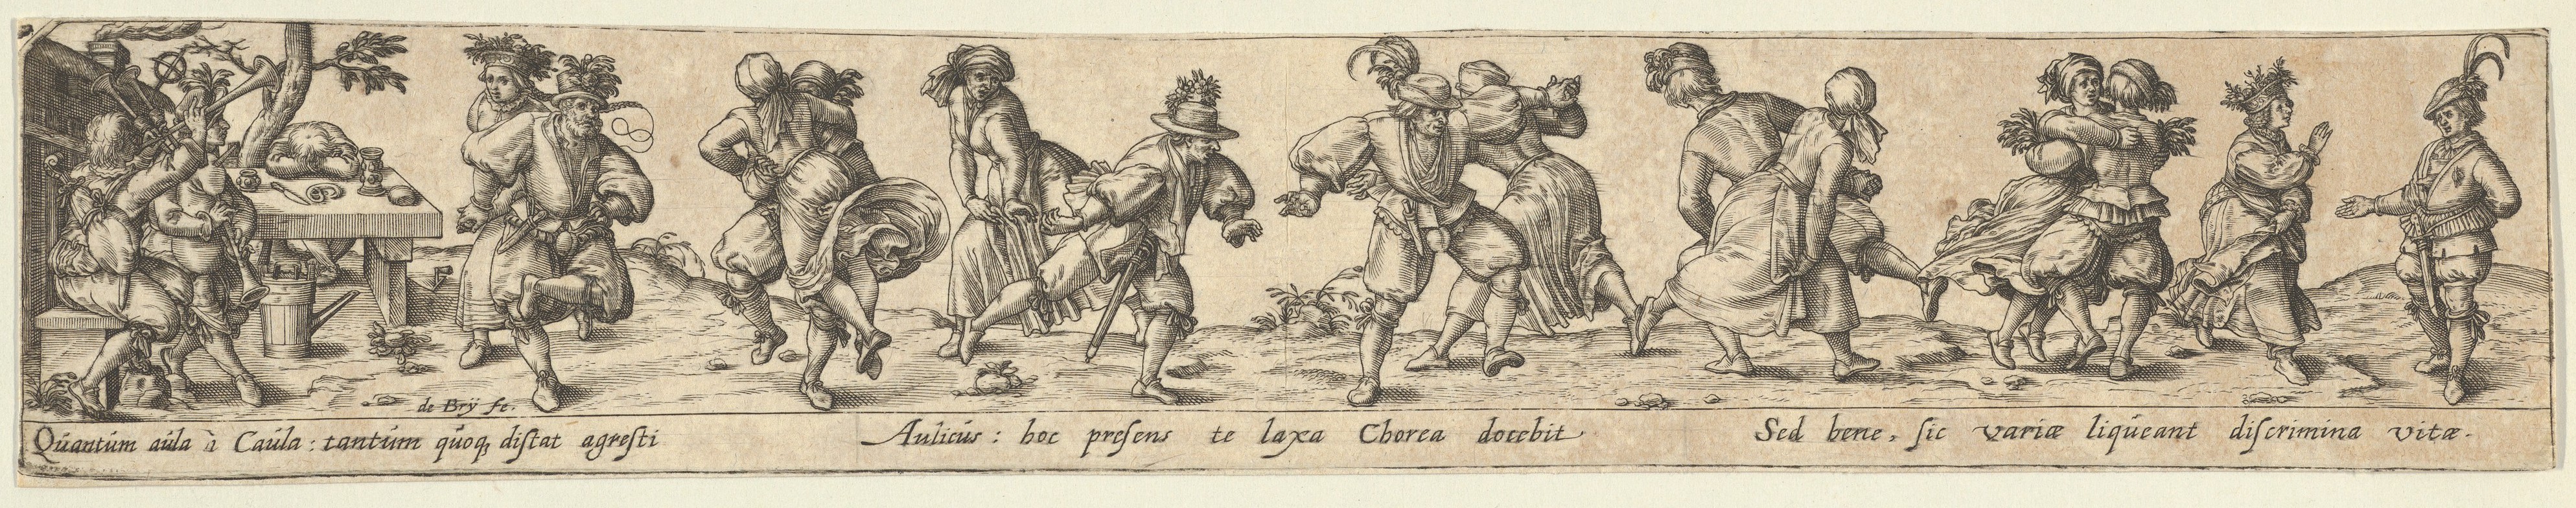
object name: print ornament architecture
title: Peasant Couples Dancing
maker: johann theodor de bry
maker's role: artist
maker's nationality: netherlandish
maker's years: 1561-1623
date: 1580-1600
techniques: engraving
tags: couples,dancing,bagpipes,dancers